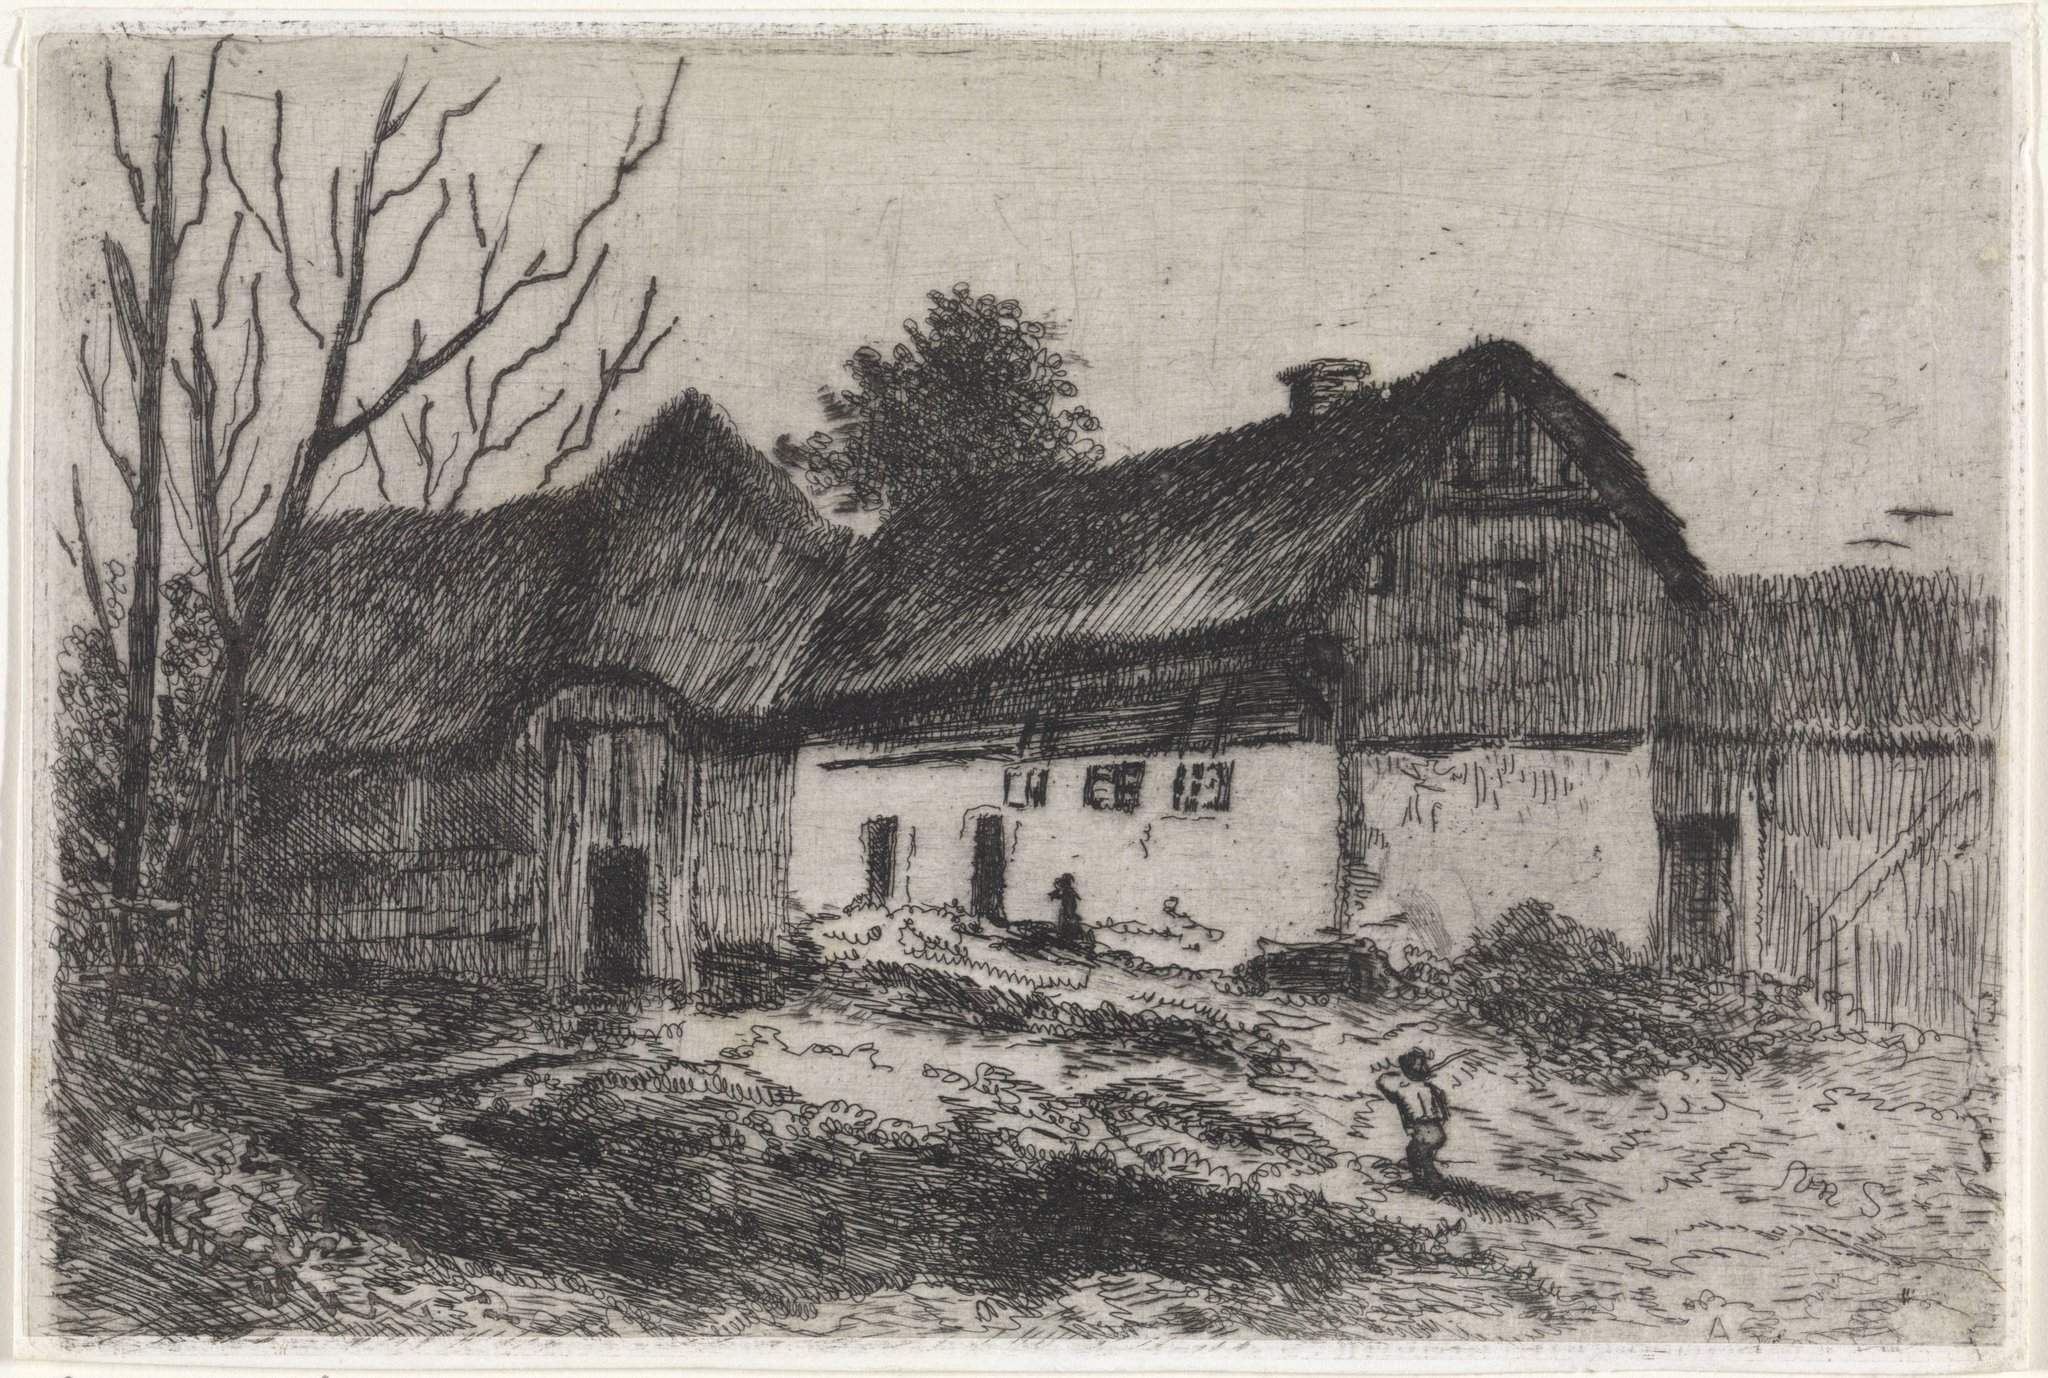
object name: print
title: Boerderij met schuur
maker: arnoud schaepkens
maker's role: print maker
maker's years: 1816-1904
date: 1855-1904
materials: paper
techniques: drypoint, etching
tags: farm or solitary house in landscape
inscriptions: collector's mark: Lugt 2228